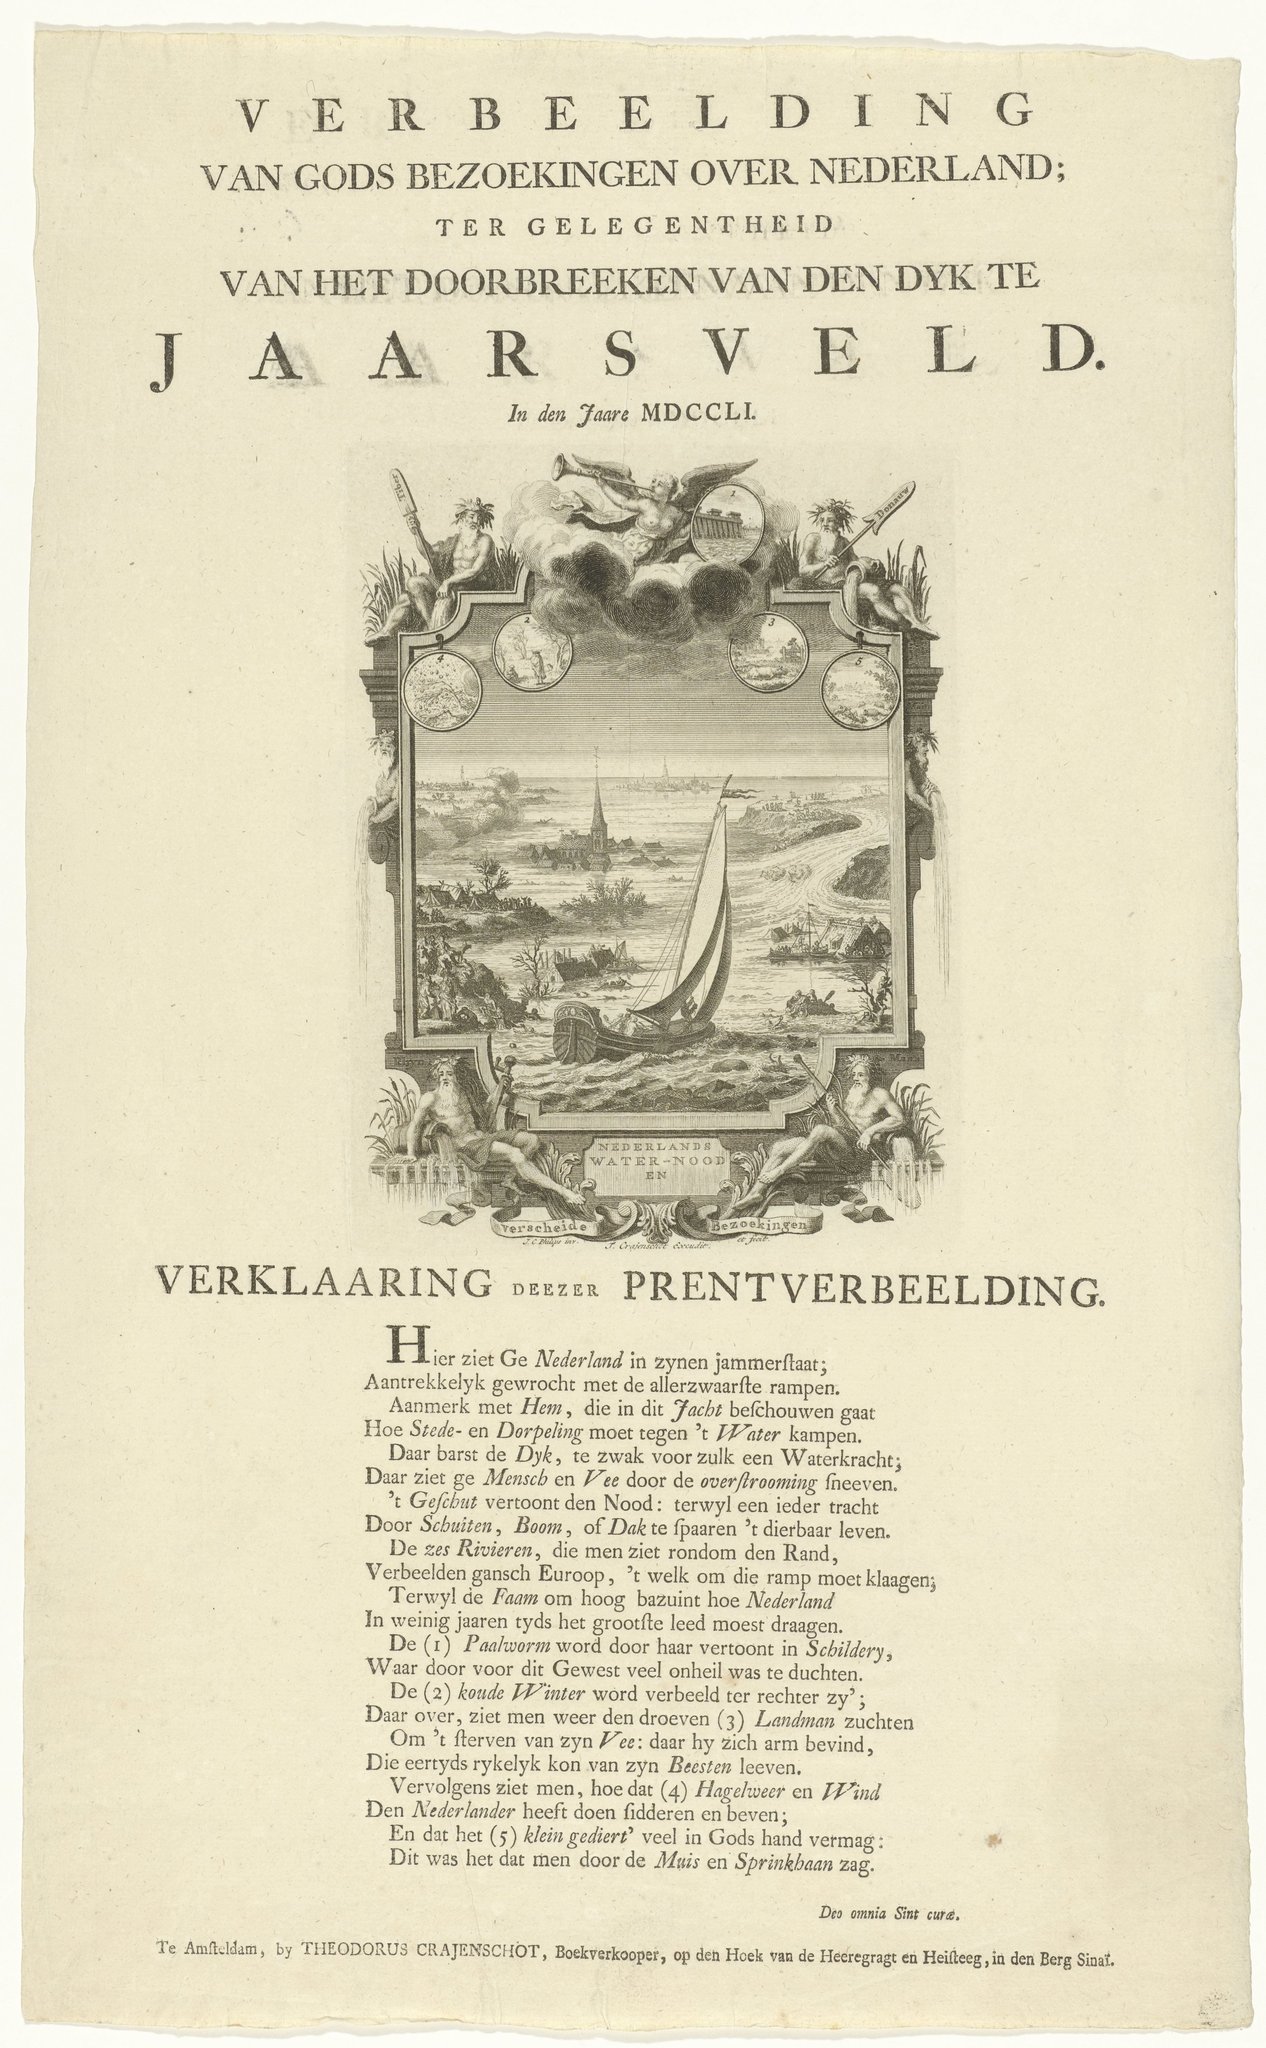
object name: text sheet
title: Nederlands Water-Nood en verscheide bezoekingen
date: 1741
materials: paper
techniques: engraving, etching, letterpress printing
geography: amsterdam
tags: dike-break, jaarsveld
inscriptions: collector's mark: Lugt 2233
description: De dijkdoorbraak te Jaarsveld, 1751. Een jacht zeilt over het overstroomde land en langs verdronken dorpen tijdens de watersnood na het doorbreken van de dijken. In allegorische omlijsting met de Faam en vier riviergoden. Op het blad onder de plaat de uitleg van de voorstelling in versvorm.